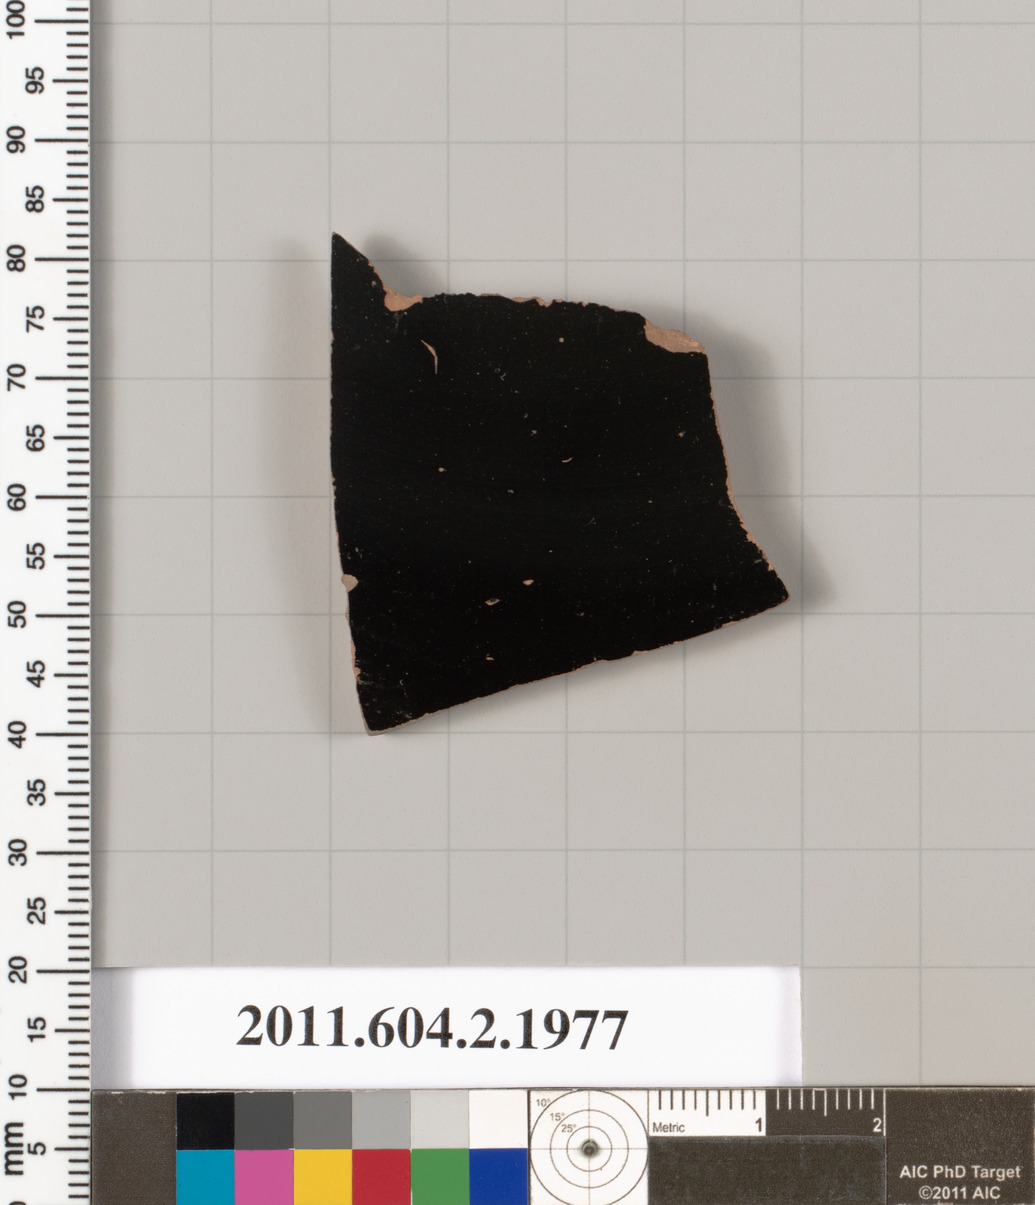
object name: pot fragment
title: Terracotta fragment of a pot; glazed on the inside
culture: greek, attic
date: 475-451 BCE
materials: terracotta